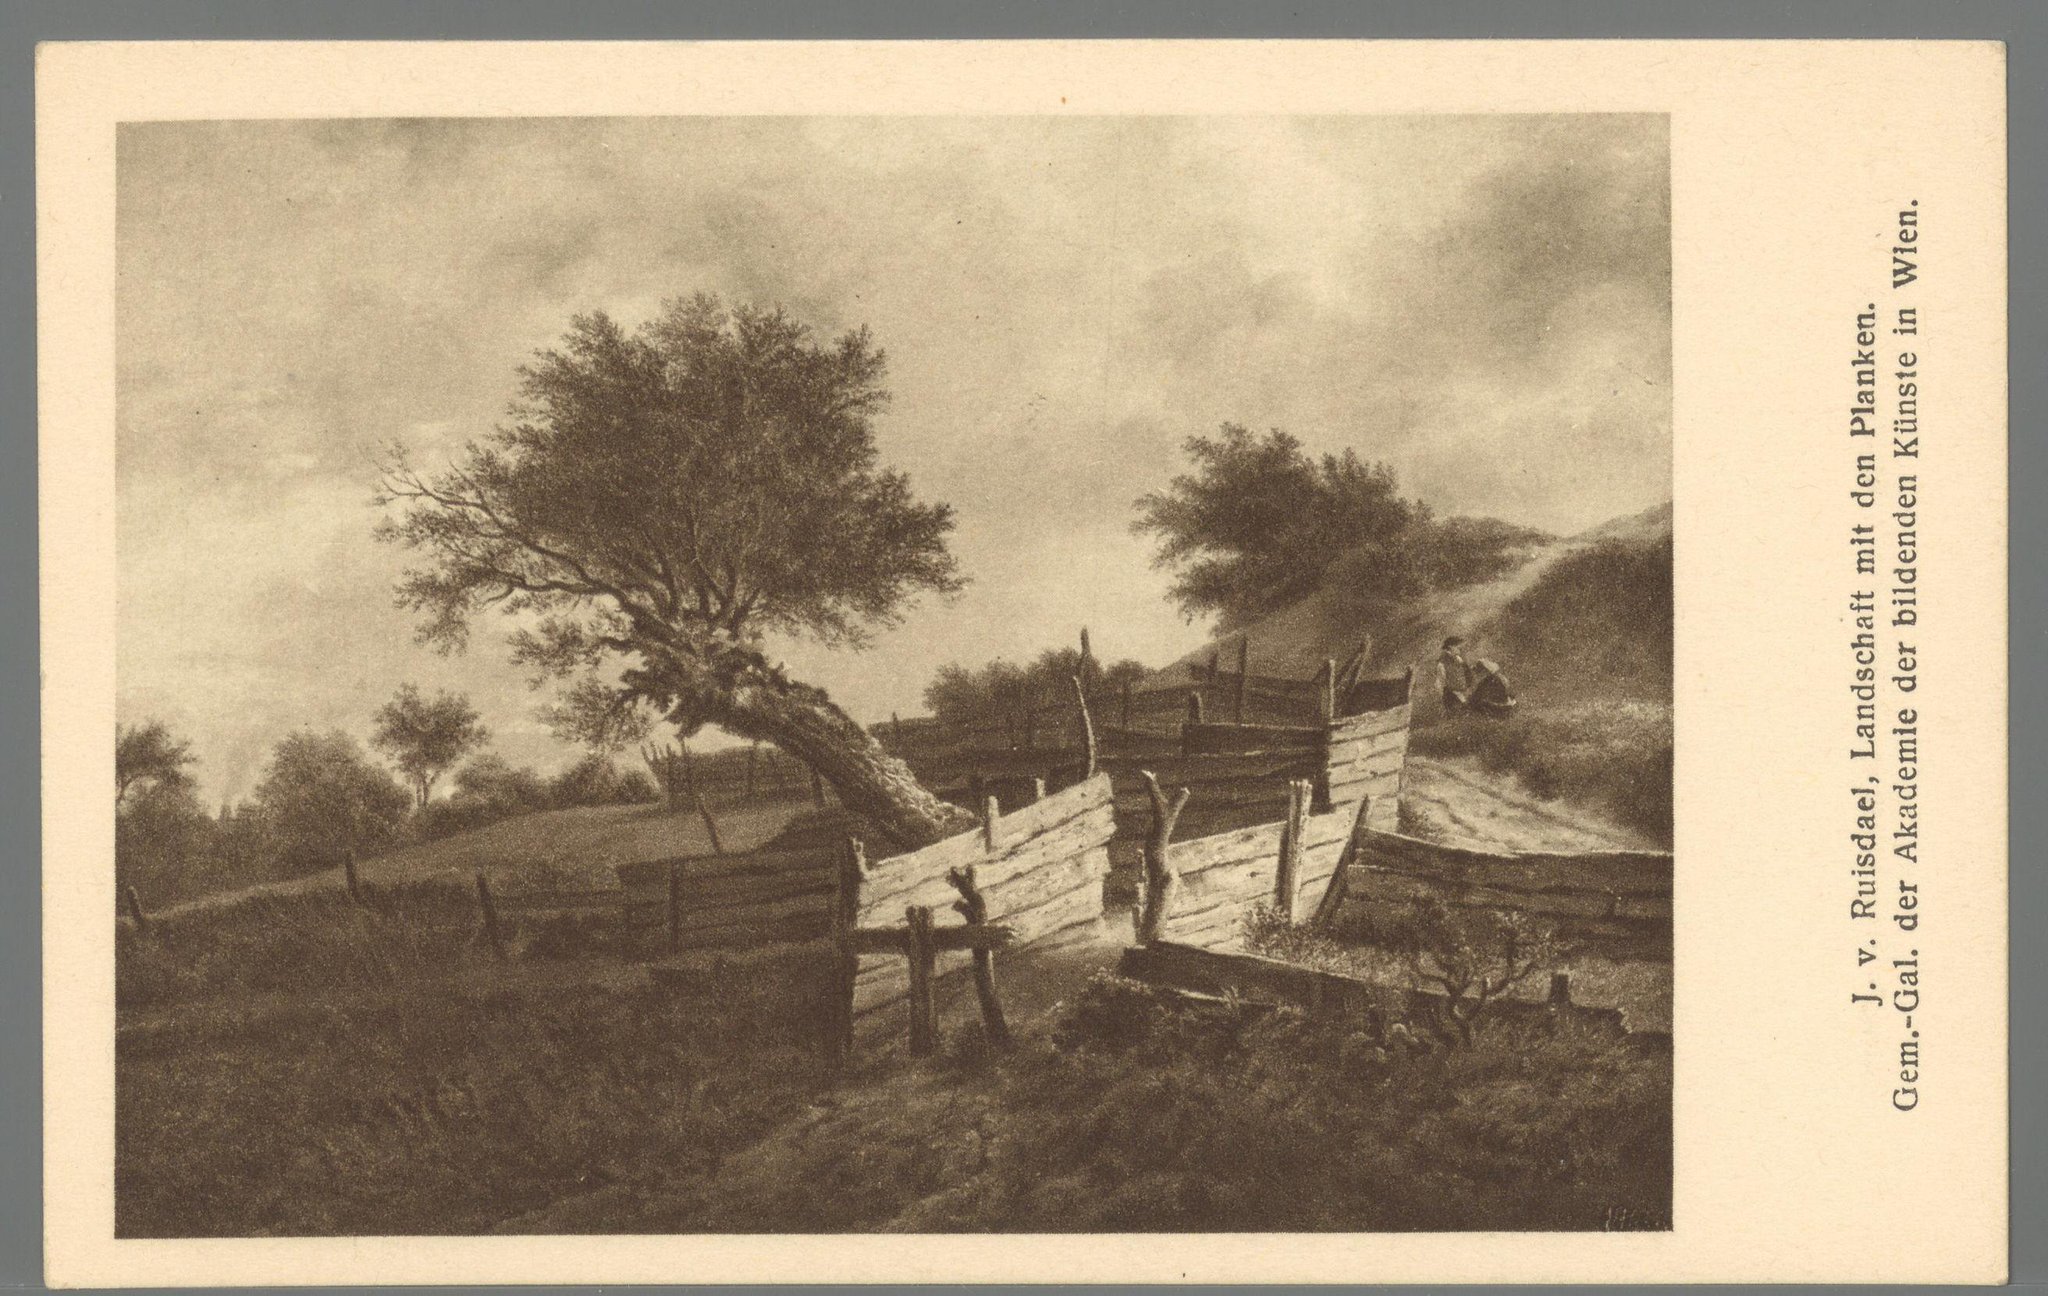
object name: ansichtkaart, prentbriefkaart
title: J. v. Ruisdael, Landschaft mit den Planken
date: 1905-1930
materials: cardboard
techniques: rotogravure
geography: vienna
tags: fence, wall, paling, plain